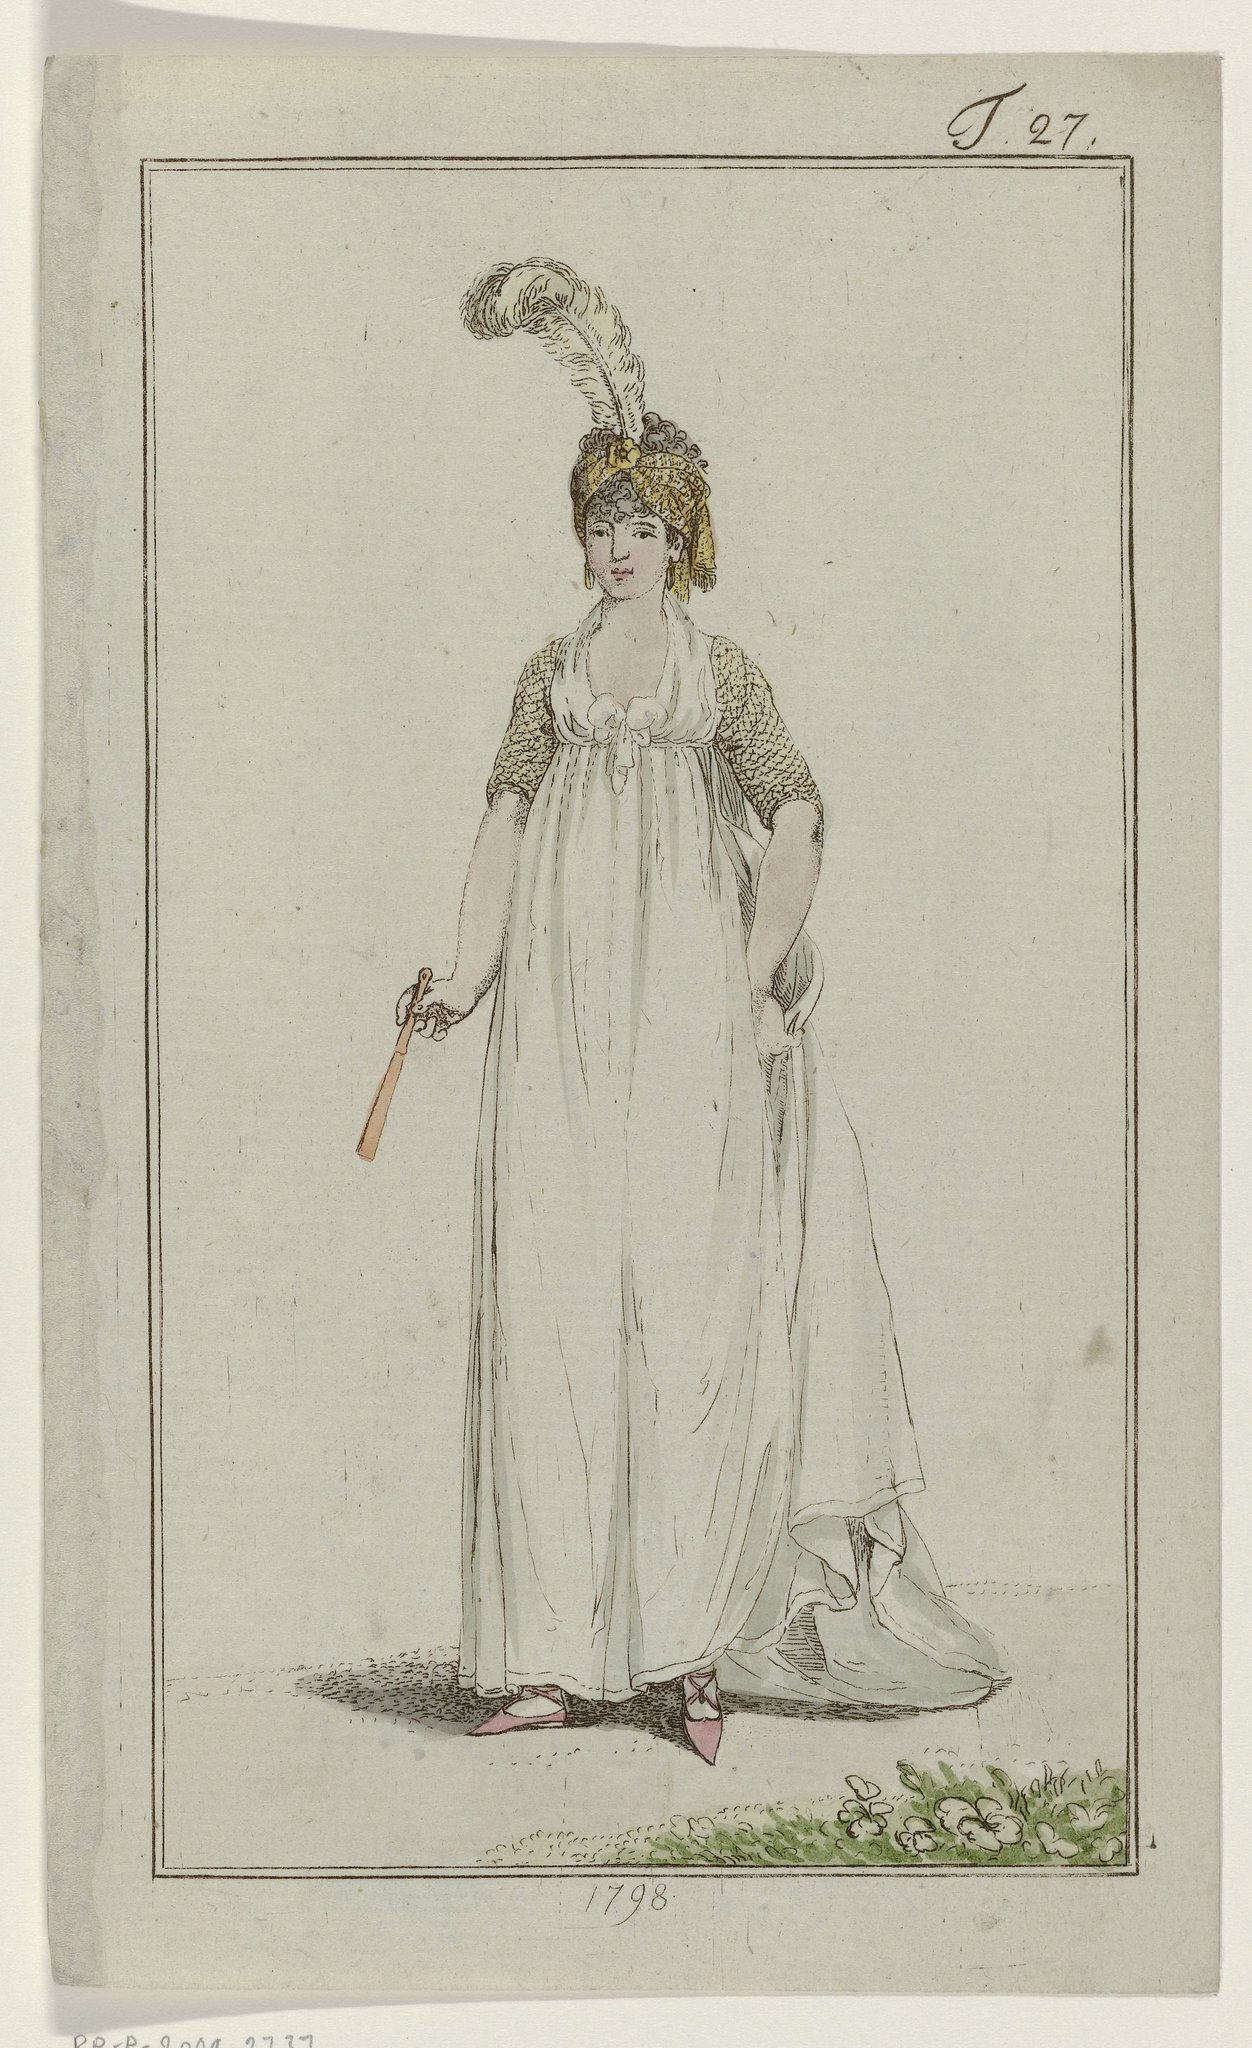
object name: fashion print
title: Journal des Luxus und der Moden, 1798, T 27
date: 1798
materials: paper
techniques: etching, hand coloring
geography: weimar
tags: ear-rings (+ women's clothes), head-gear (+ women's clothes), fashion plates, shoes, sandals (+ women's clothes), dress, gown (+ women's clothes), fan (+ women's clothes)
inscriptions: date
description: Staande vrouw gekleed in een japon met halflange mouwen, hoge taille en sleep. Om het hoofd een sjaal met struisveer. Verdere accessoires: oorbellen, waaier, platte schoenen met gekruiste banden en puntige neuzen. Prent uit het modetijdschrift Journal des Luxus und der Moden, uitgegeven door Friedrich Justin Bertuch en Georg Melchior Kraus, Weimar, 1786-1826.